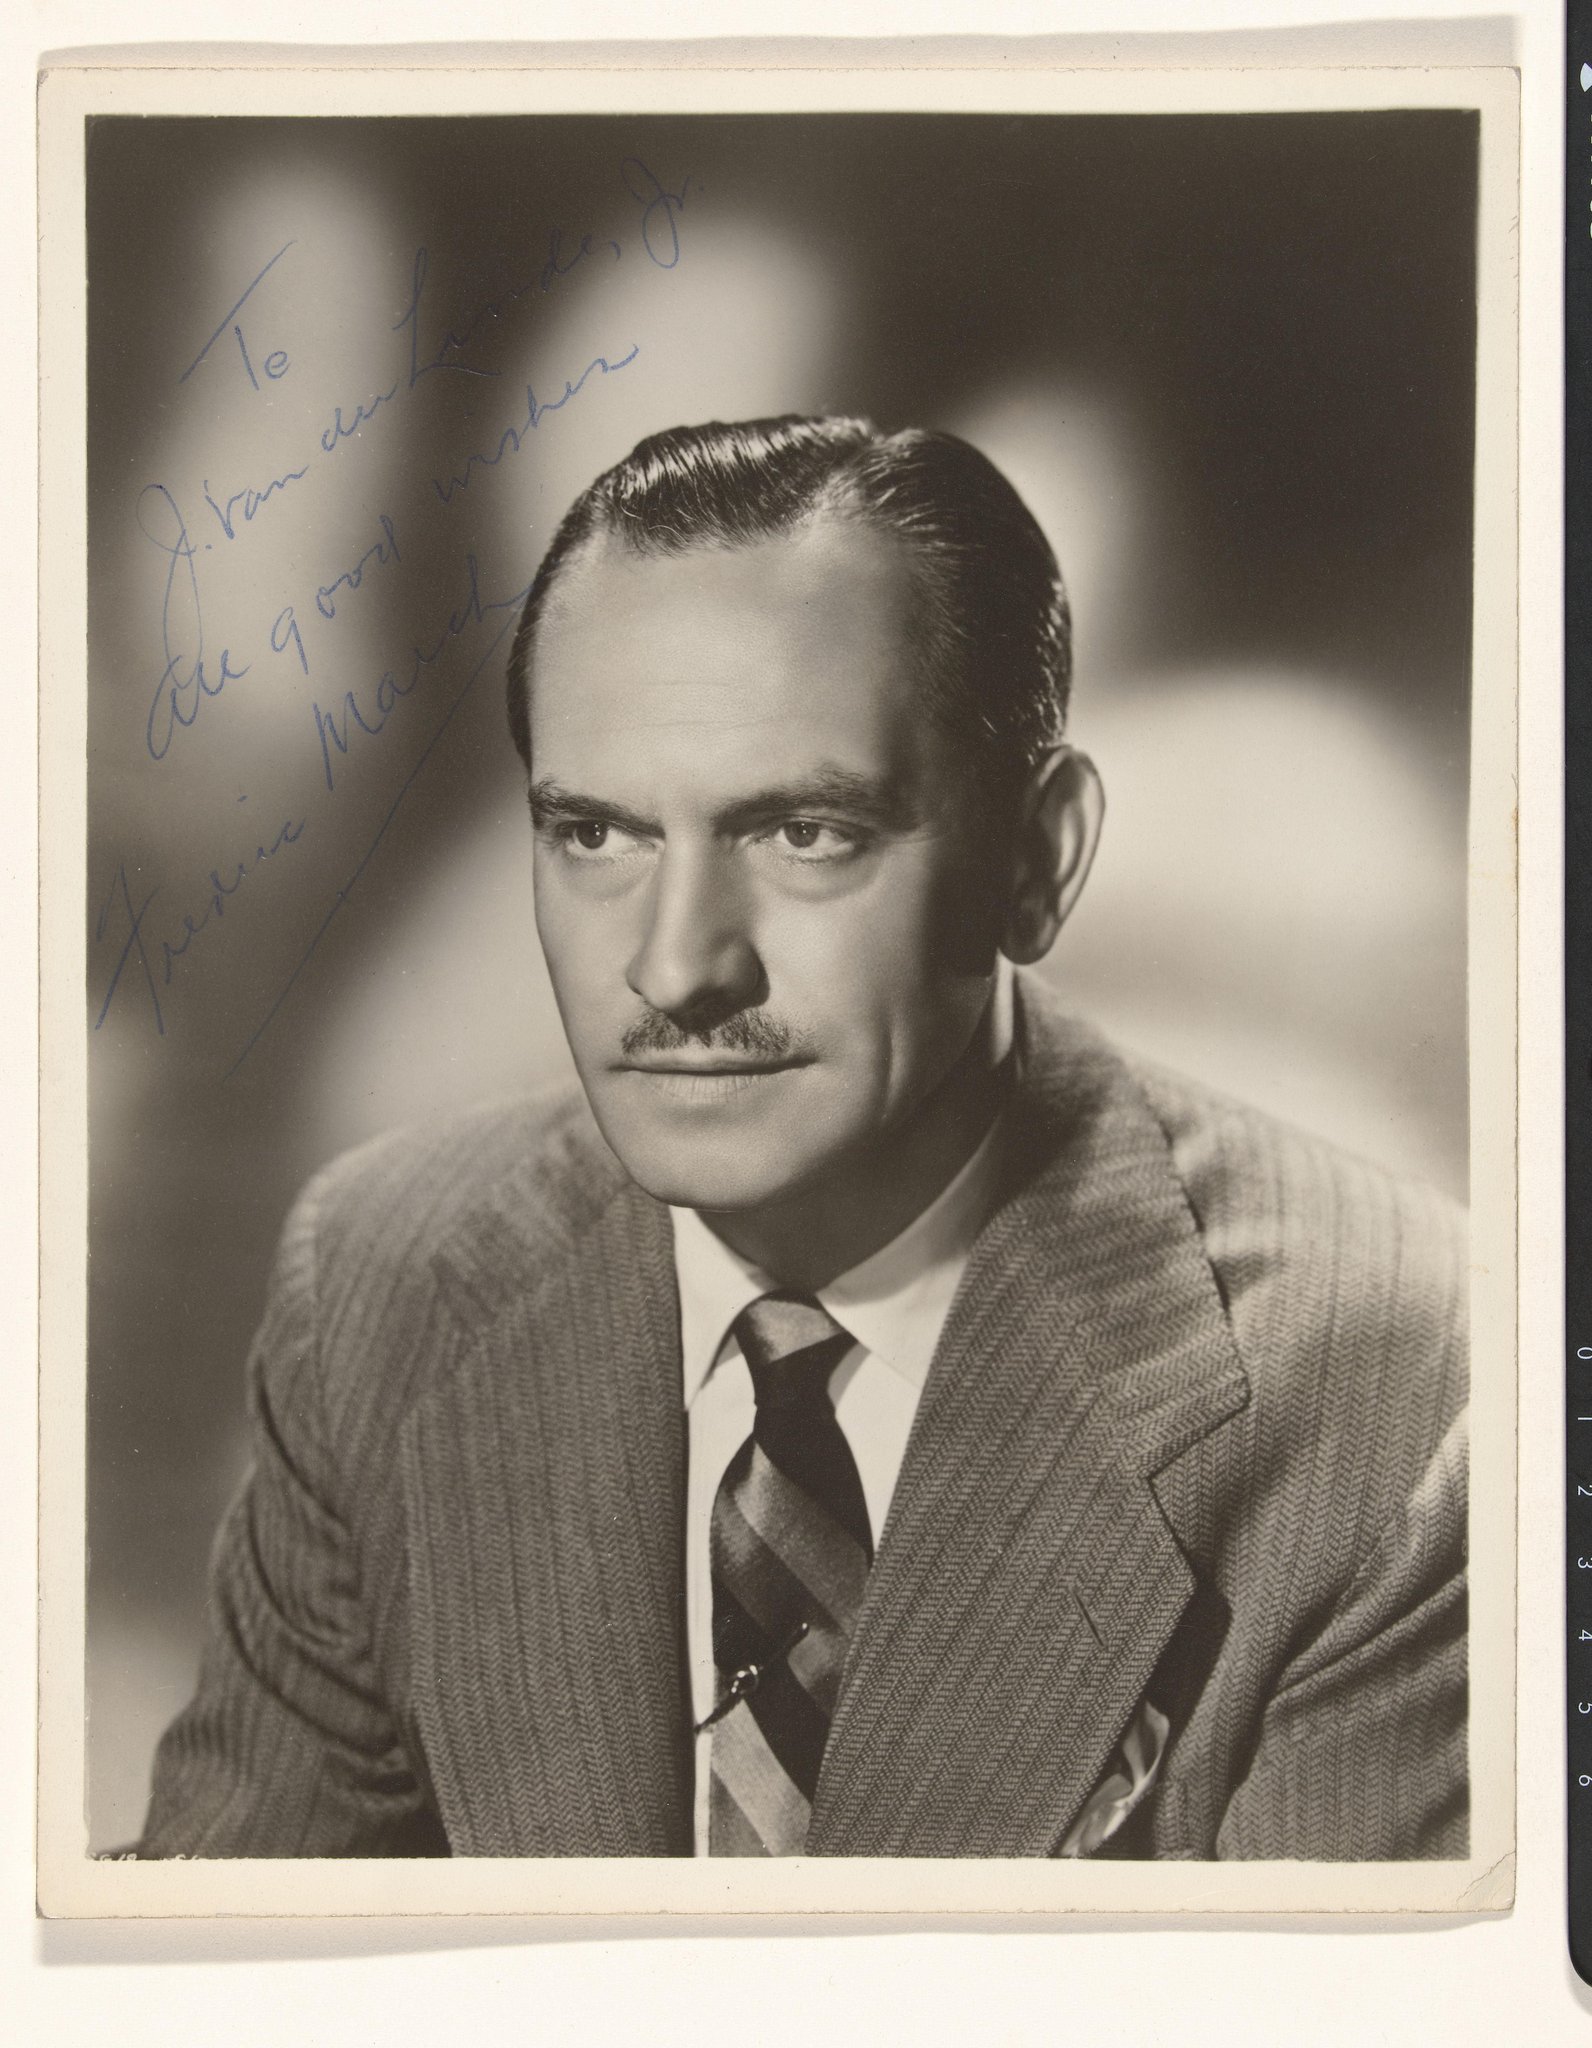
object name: photograph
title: To J van den Linde jr. all good wishes, Frederic March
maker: Anonymous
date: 1935-1946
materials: photographic support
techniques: gelatin silver print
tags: acteur, march frederic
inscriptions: inscription: ‘Frederic March (Anna Karenina (1935) + Greta Garbo, I married a wicht (1942) Mark Twain (1944) The best years of our lives (1946))’